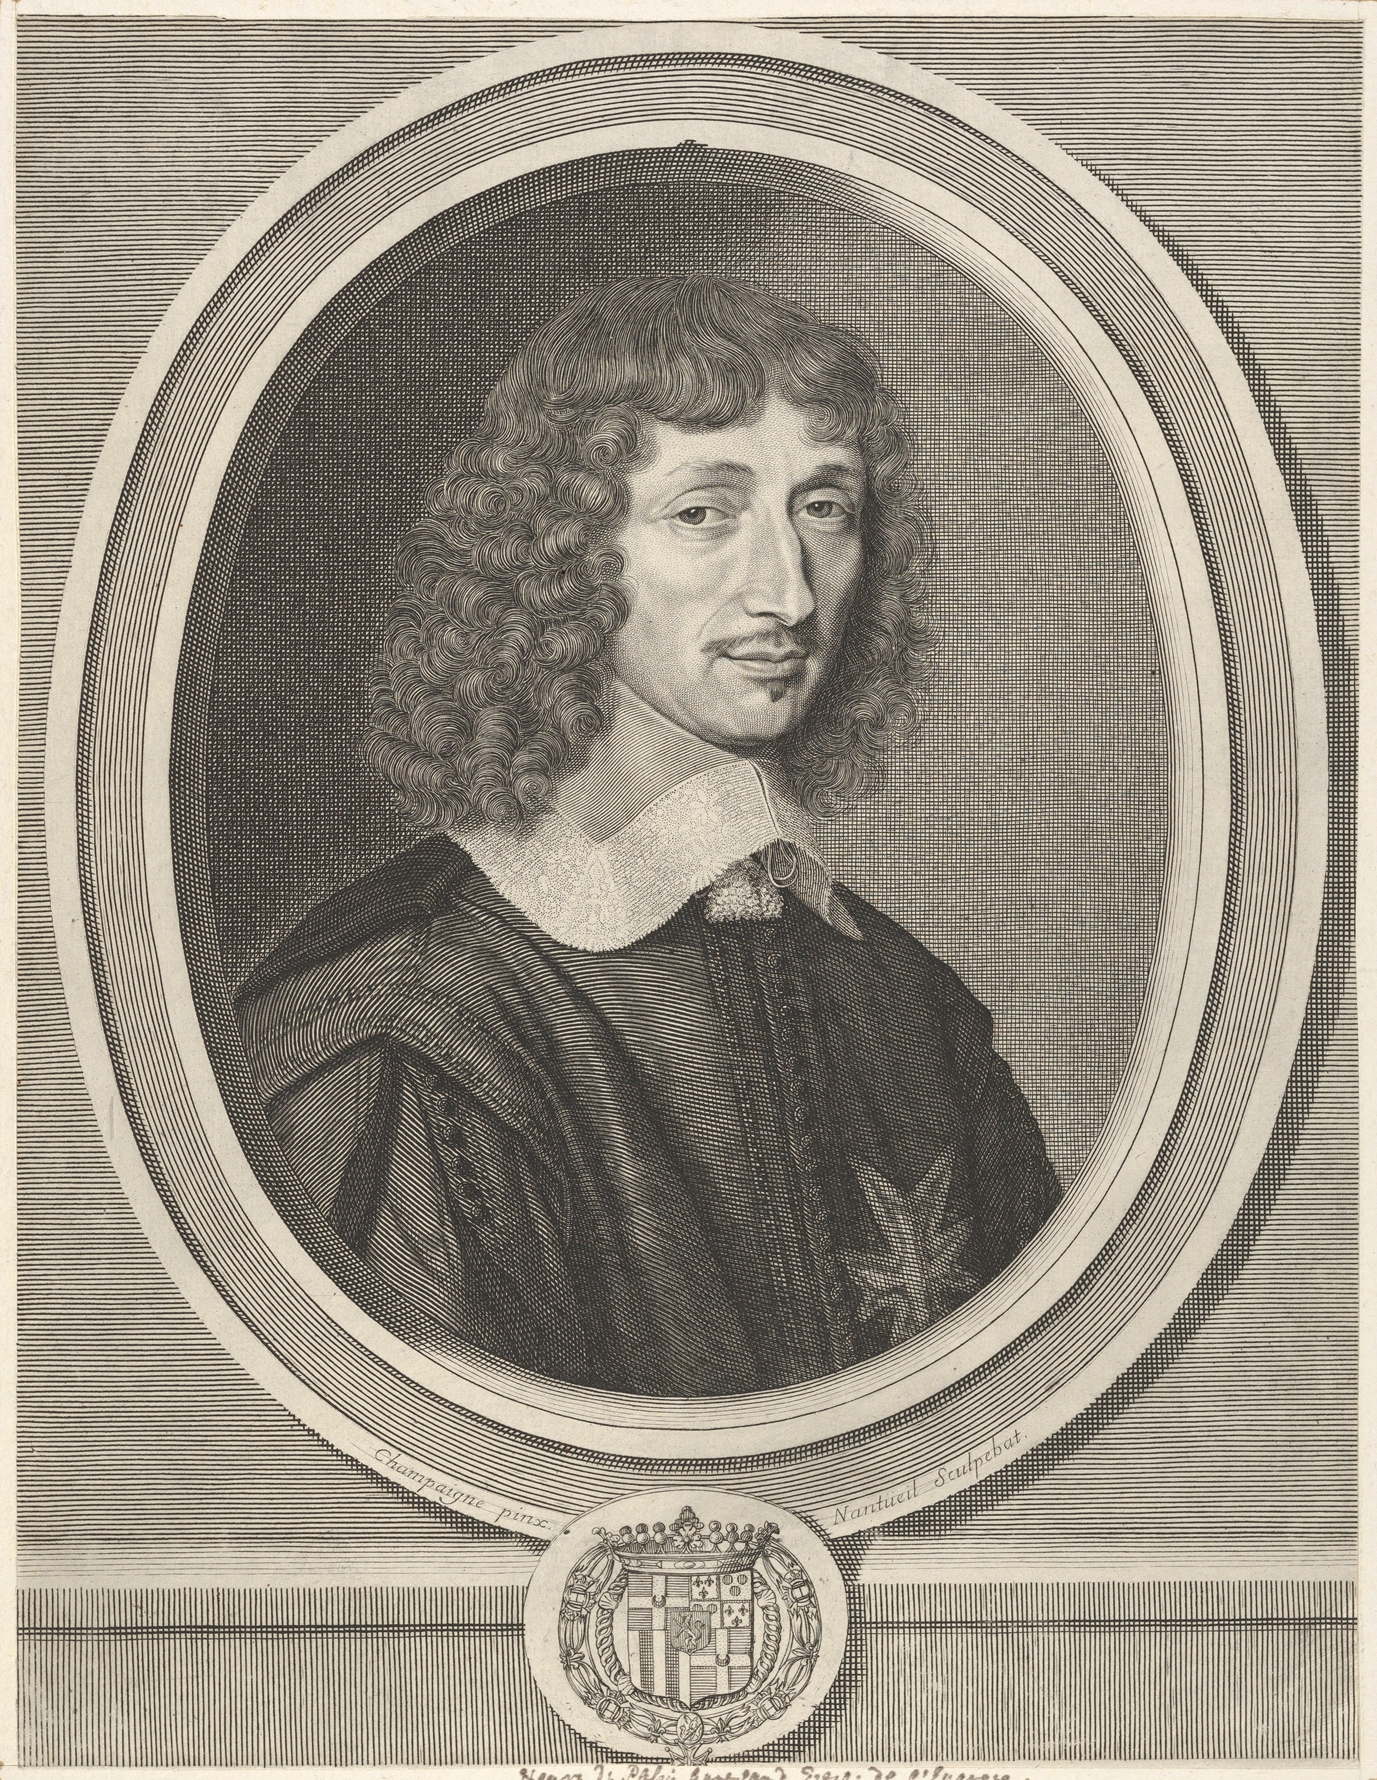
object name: print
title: Henri de Guénégaud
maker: robert nanteuil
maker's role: artist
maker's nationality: french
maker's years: 1623-1678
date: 1654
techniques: engraving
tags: men,portraits,coat of arms